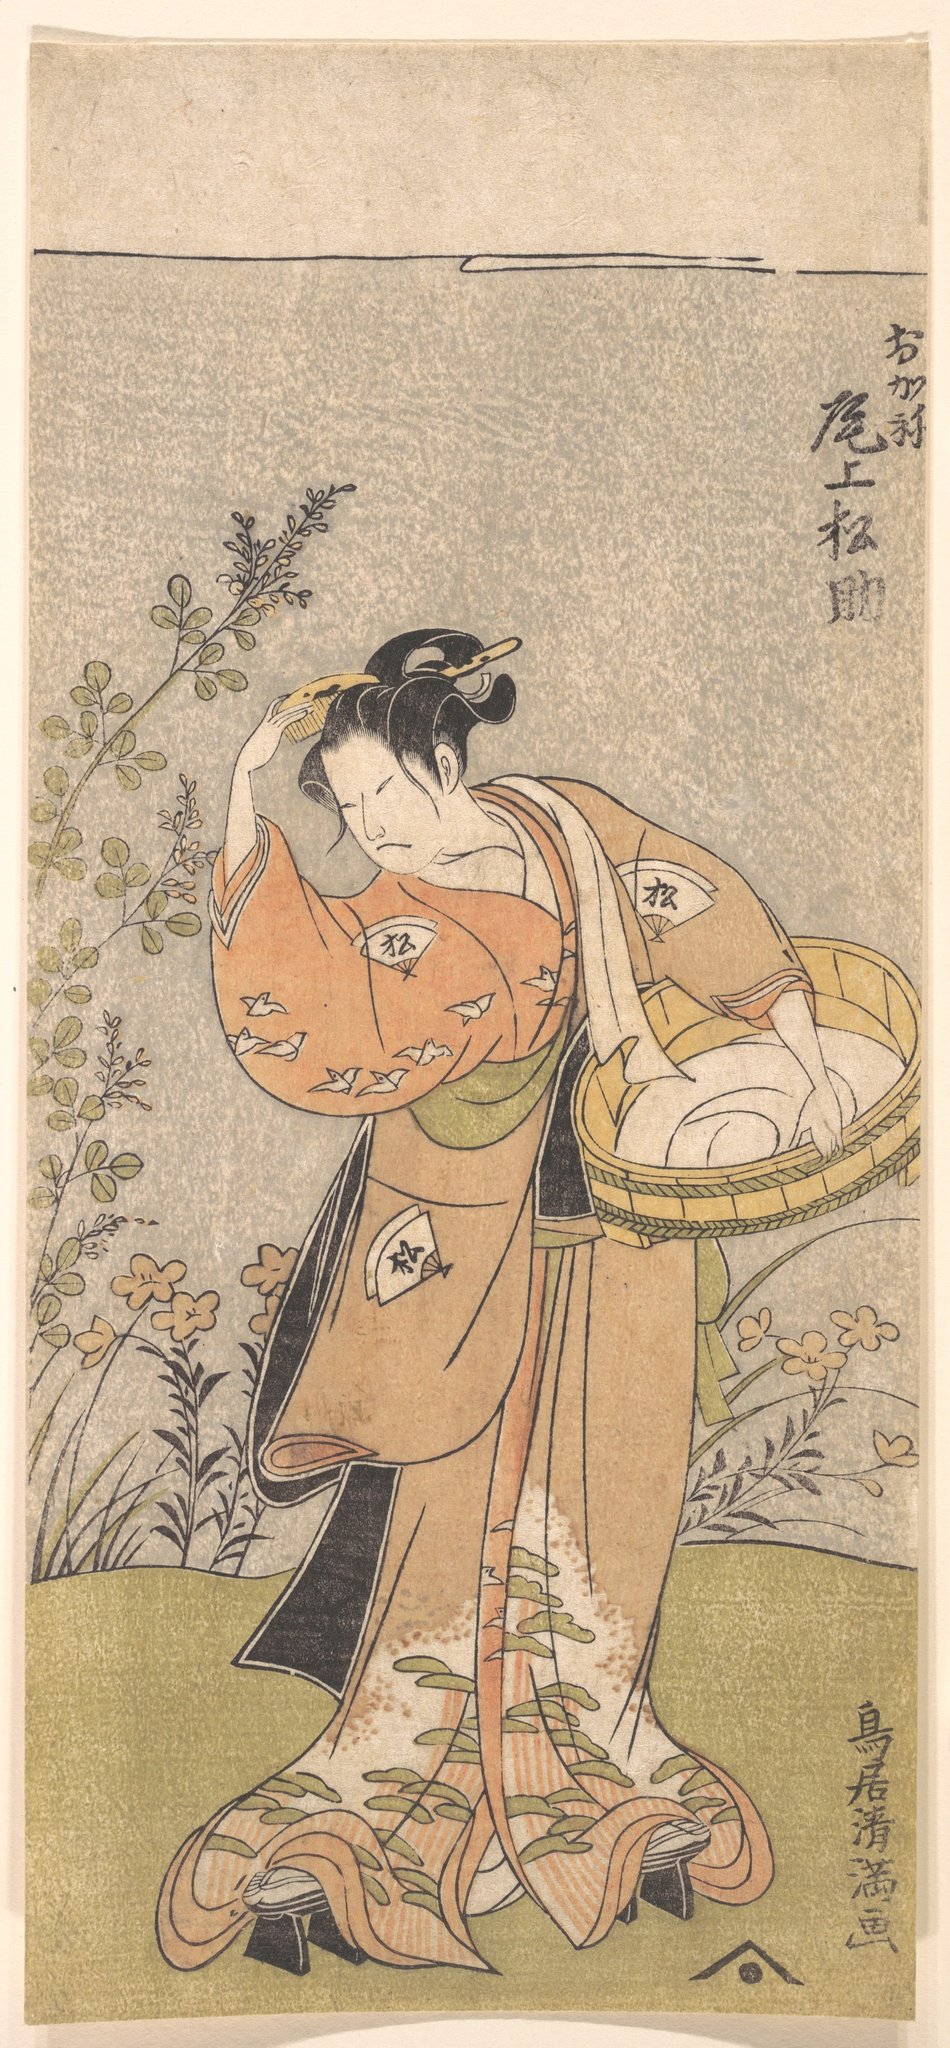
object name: woodblock print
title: The Actor Onoya Matsusuke, in Female Robe of O-Kane, Adjusts the Comb in His Hair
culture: japanese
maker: torii kiyomitsu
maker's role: artist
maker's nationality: japanese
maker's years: 1735-1785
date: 1735-1785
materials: ink, paper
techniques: woodblock print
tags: flowers,actors